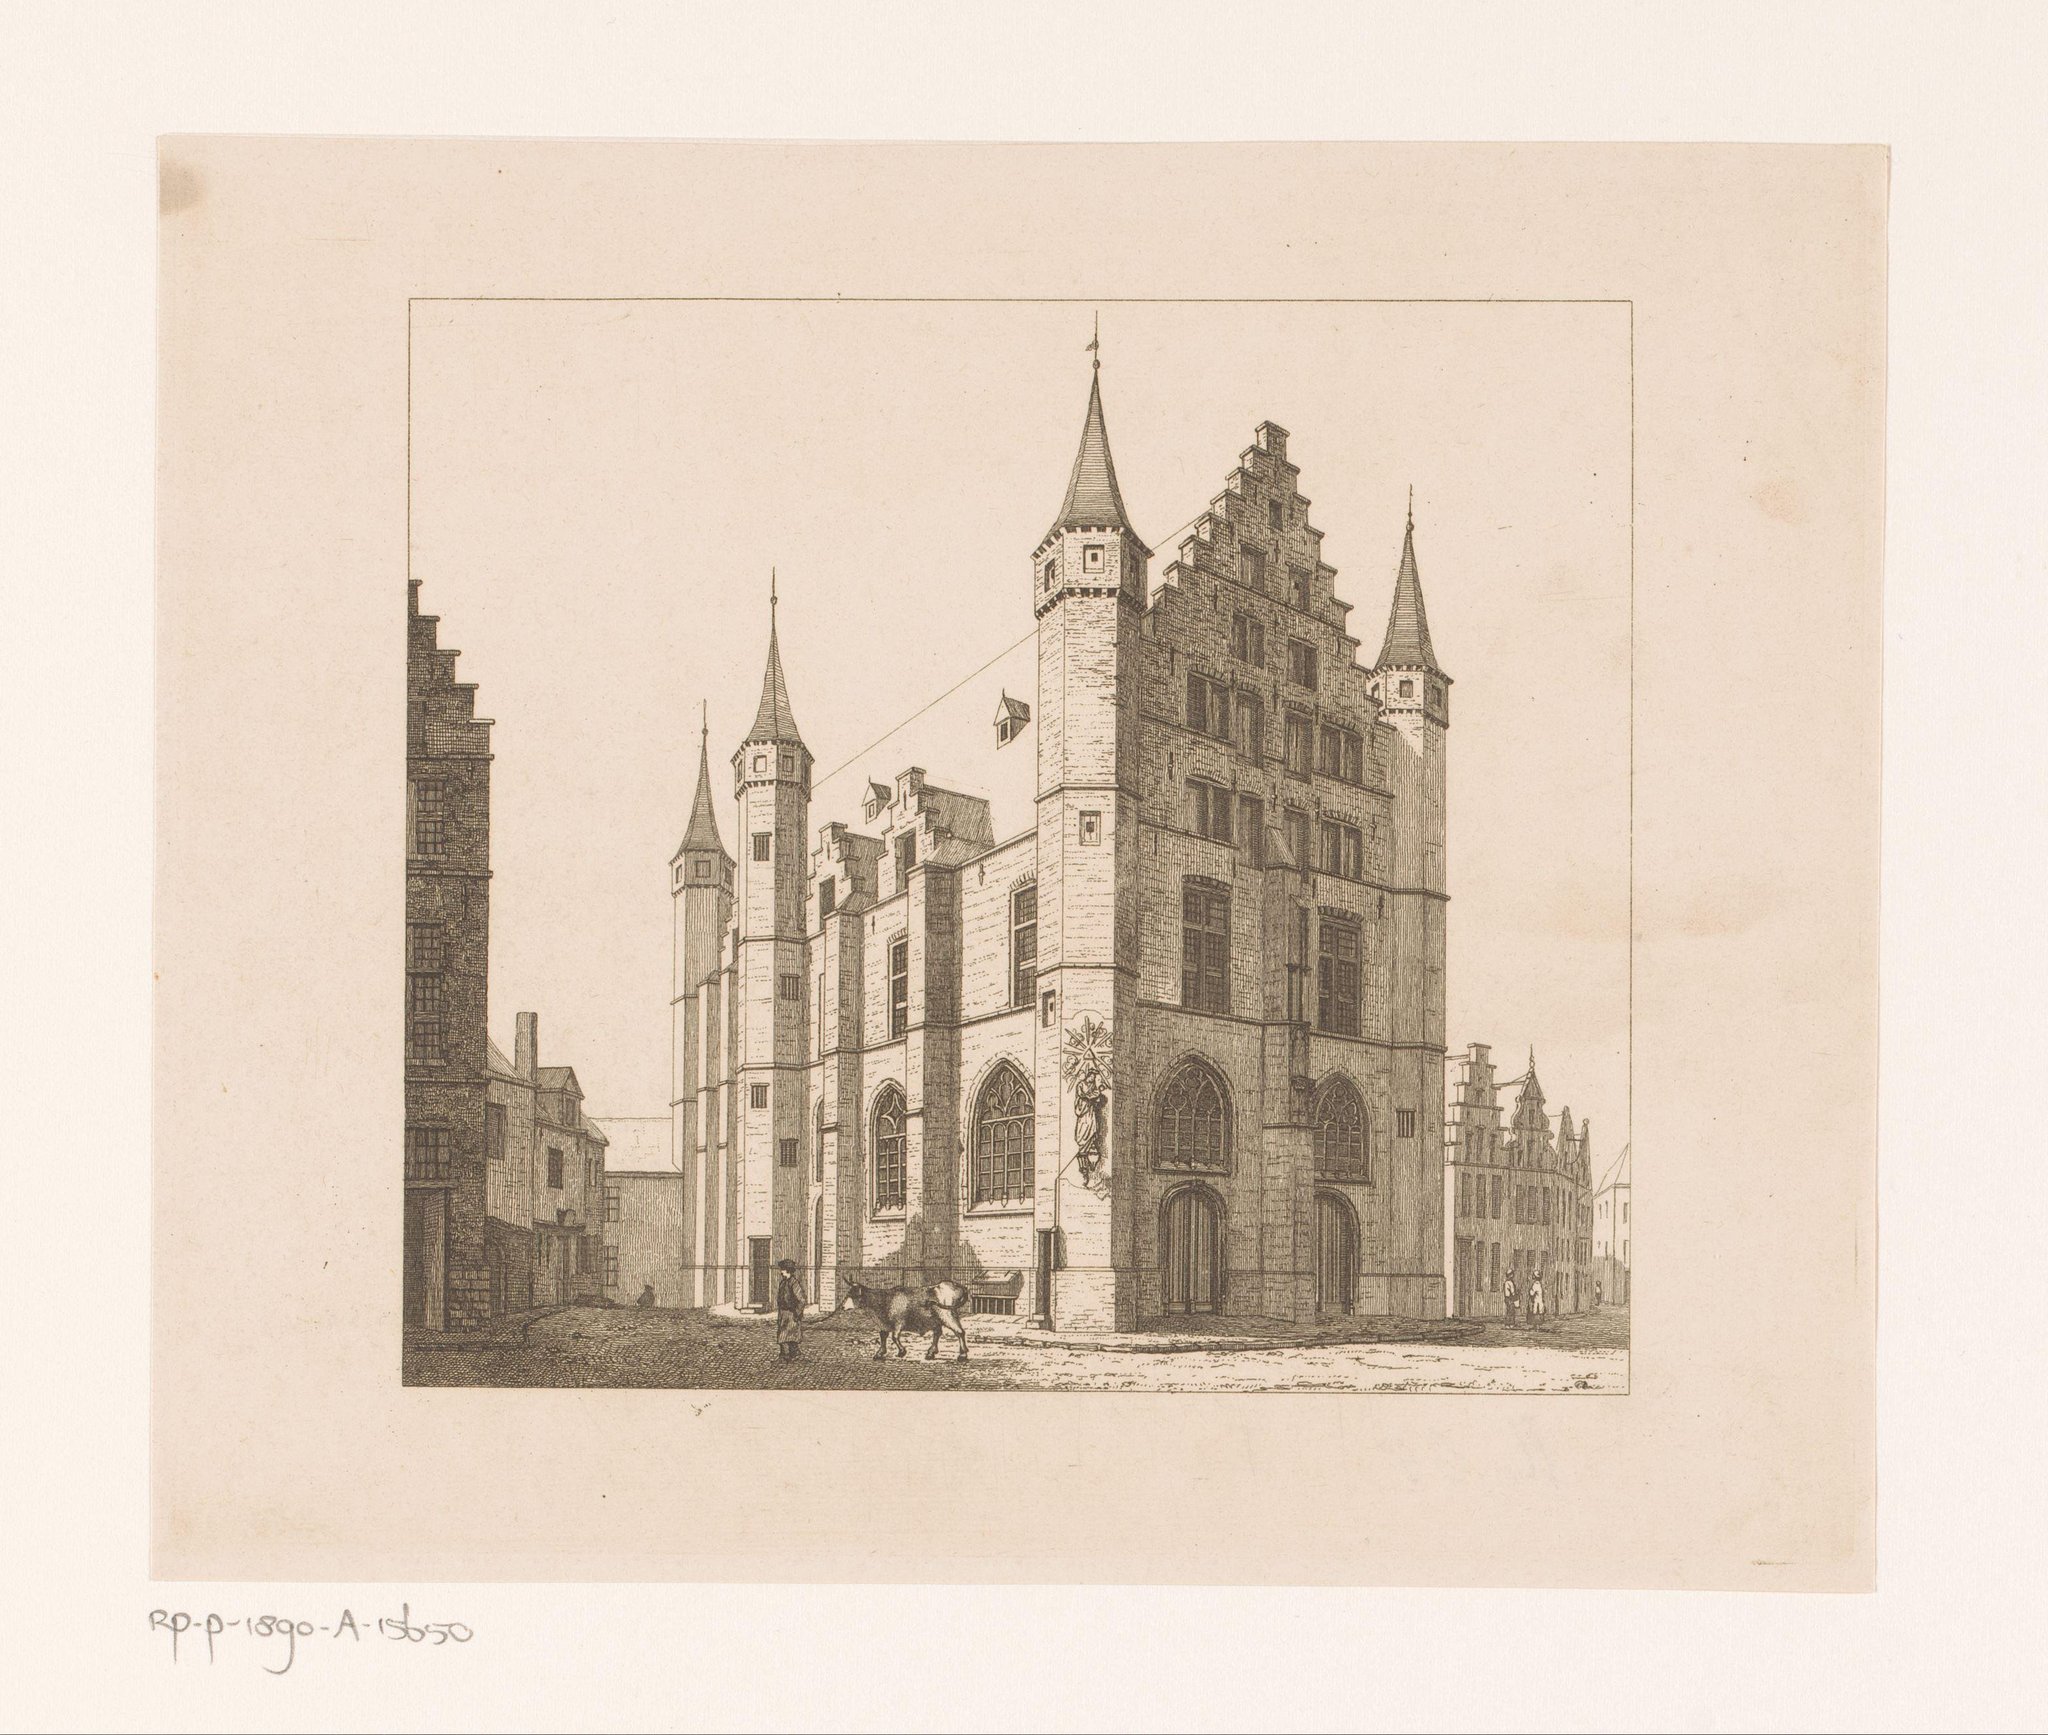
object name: print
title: Vleeshal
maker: jean théodore joseph linnig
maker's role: draughtsman, print maker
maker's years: 1815-1891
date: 1849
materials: paper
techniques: etching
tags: market-hall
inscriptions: collector's mark: Lugt 2228